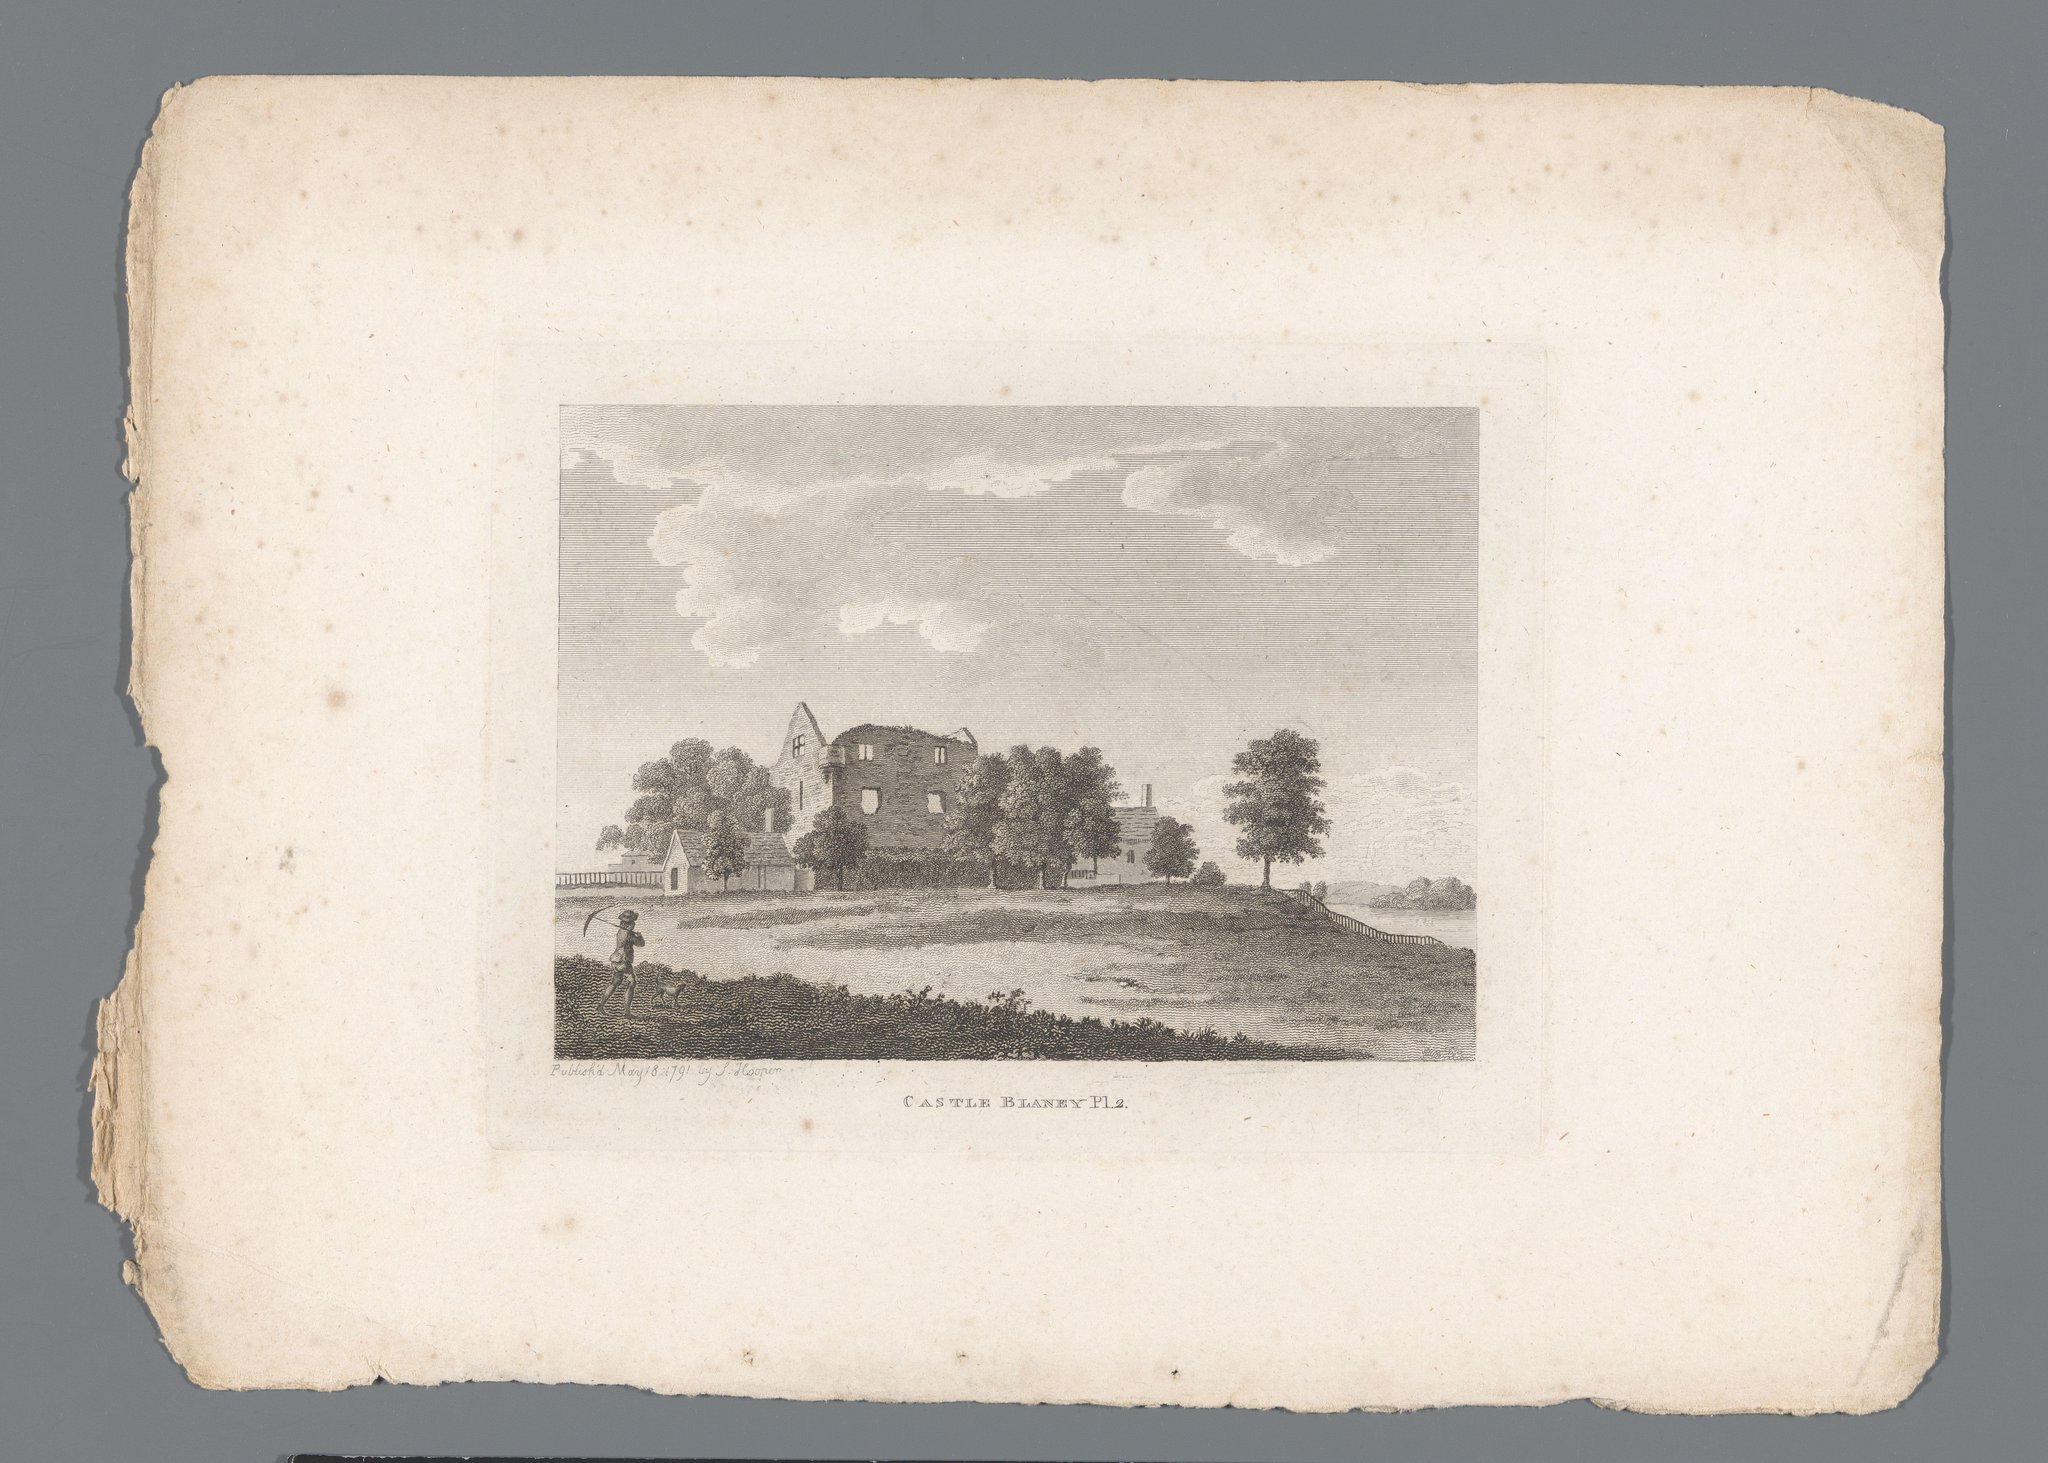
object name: book illustration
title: Gezicht op de ruïnes van Blaney Castle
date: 1791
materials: paper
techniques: etching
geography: london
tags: landscape with ruins, landscape with tower or castle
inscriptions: date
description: Prent verschenen in: Grose, Francis. The antiquities of Ireland. Londen: S. Hooper, 1795, dl. 2.